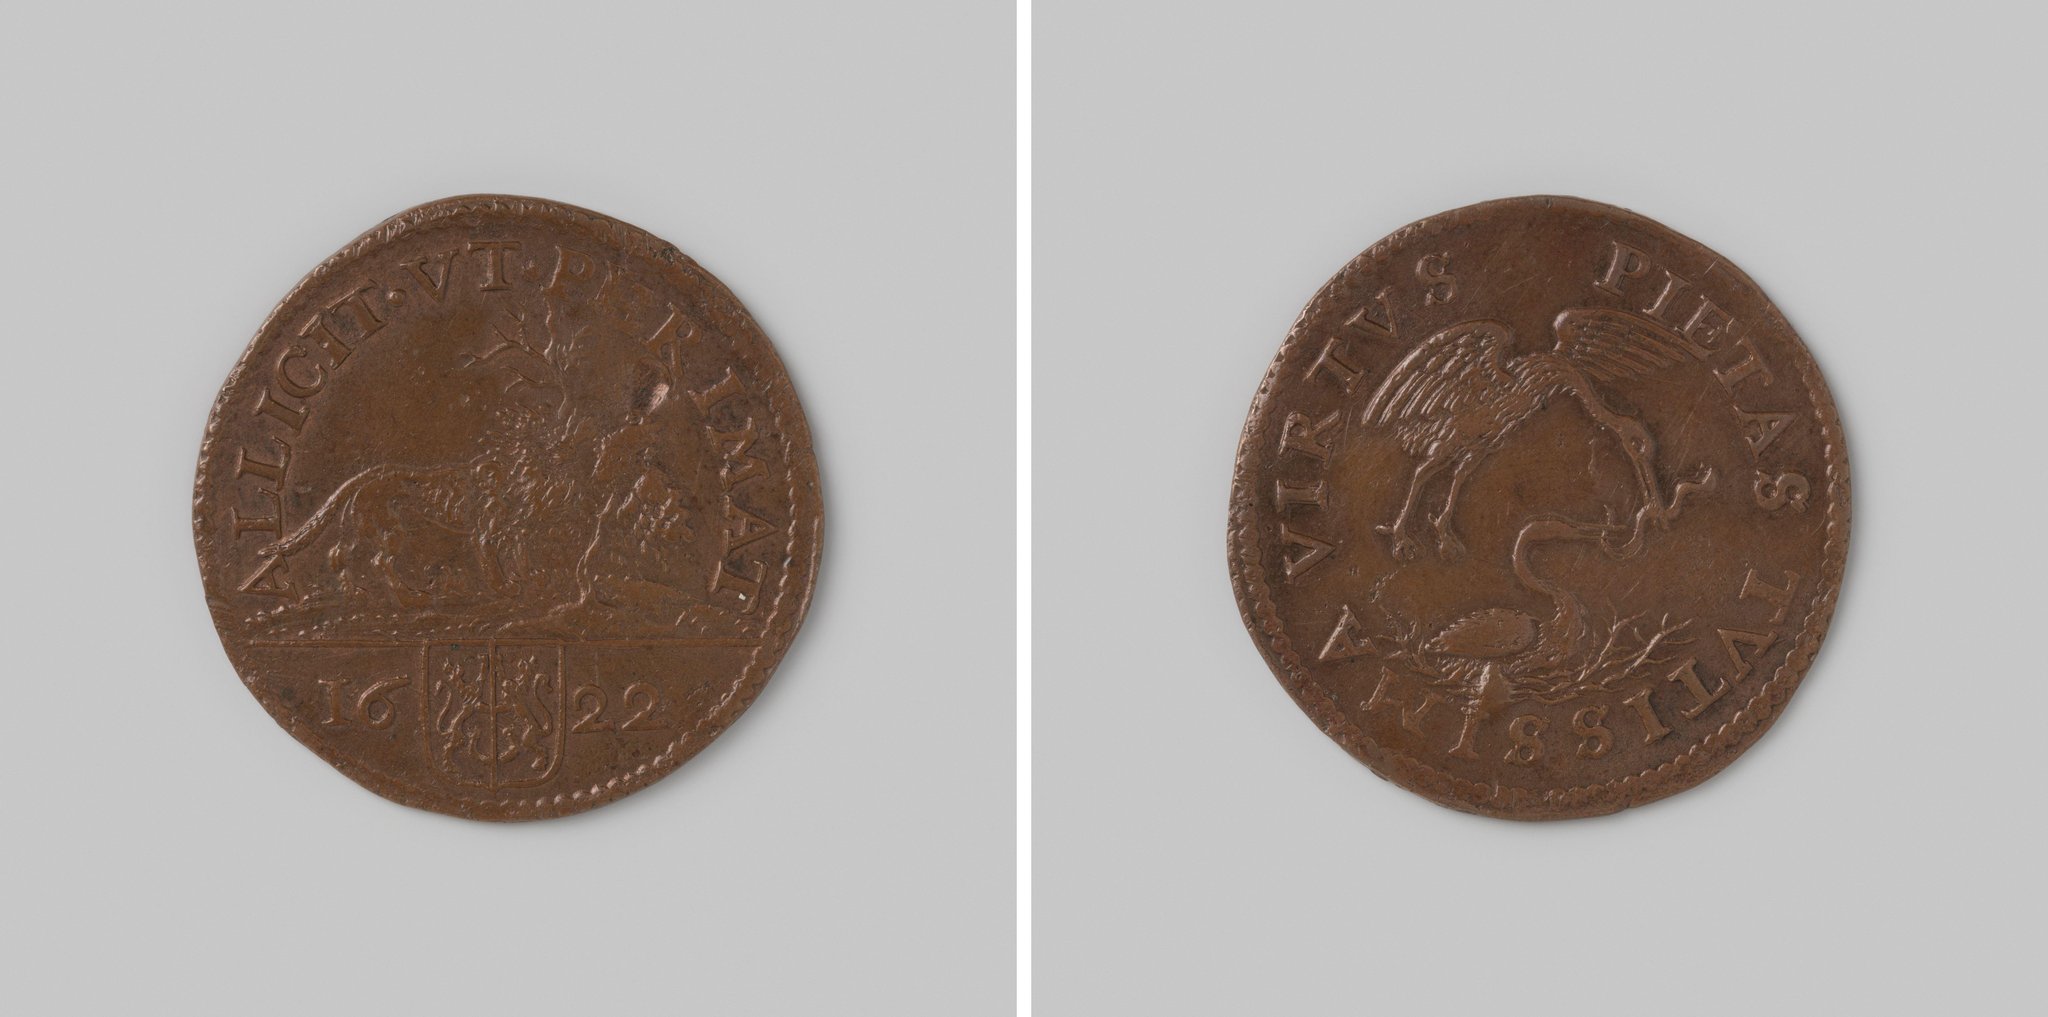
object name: jeton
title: Rekenpenning uit Gelderland op het opheffen van het beleg van Bergen op Zoom 1622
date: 1622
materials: copper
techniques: striking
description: Koperen penning, op de voorzijde een leeuw naar rechts eet druiven van een struik, met omschrift en afsnedetekst, op de keerzijde een ooievaar die zijn jong een slang voert, met omschrift.